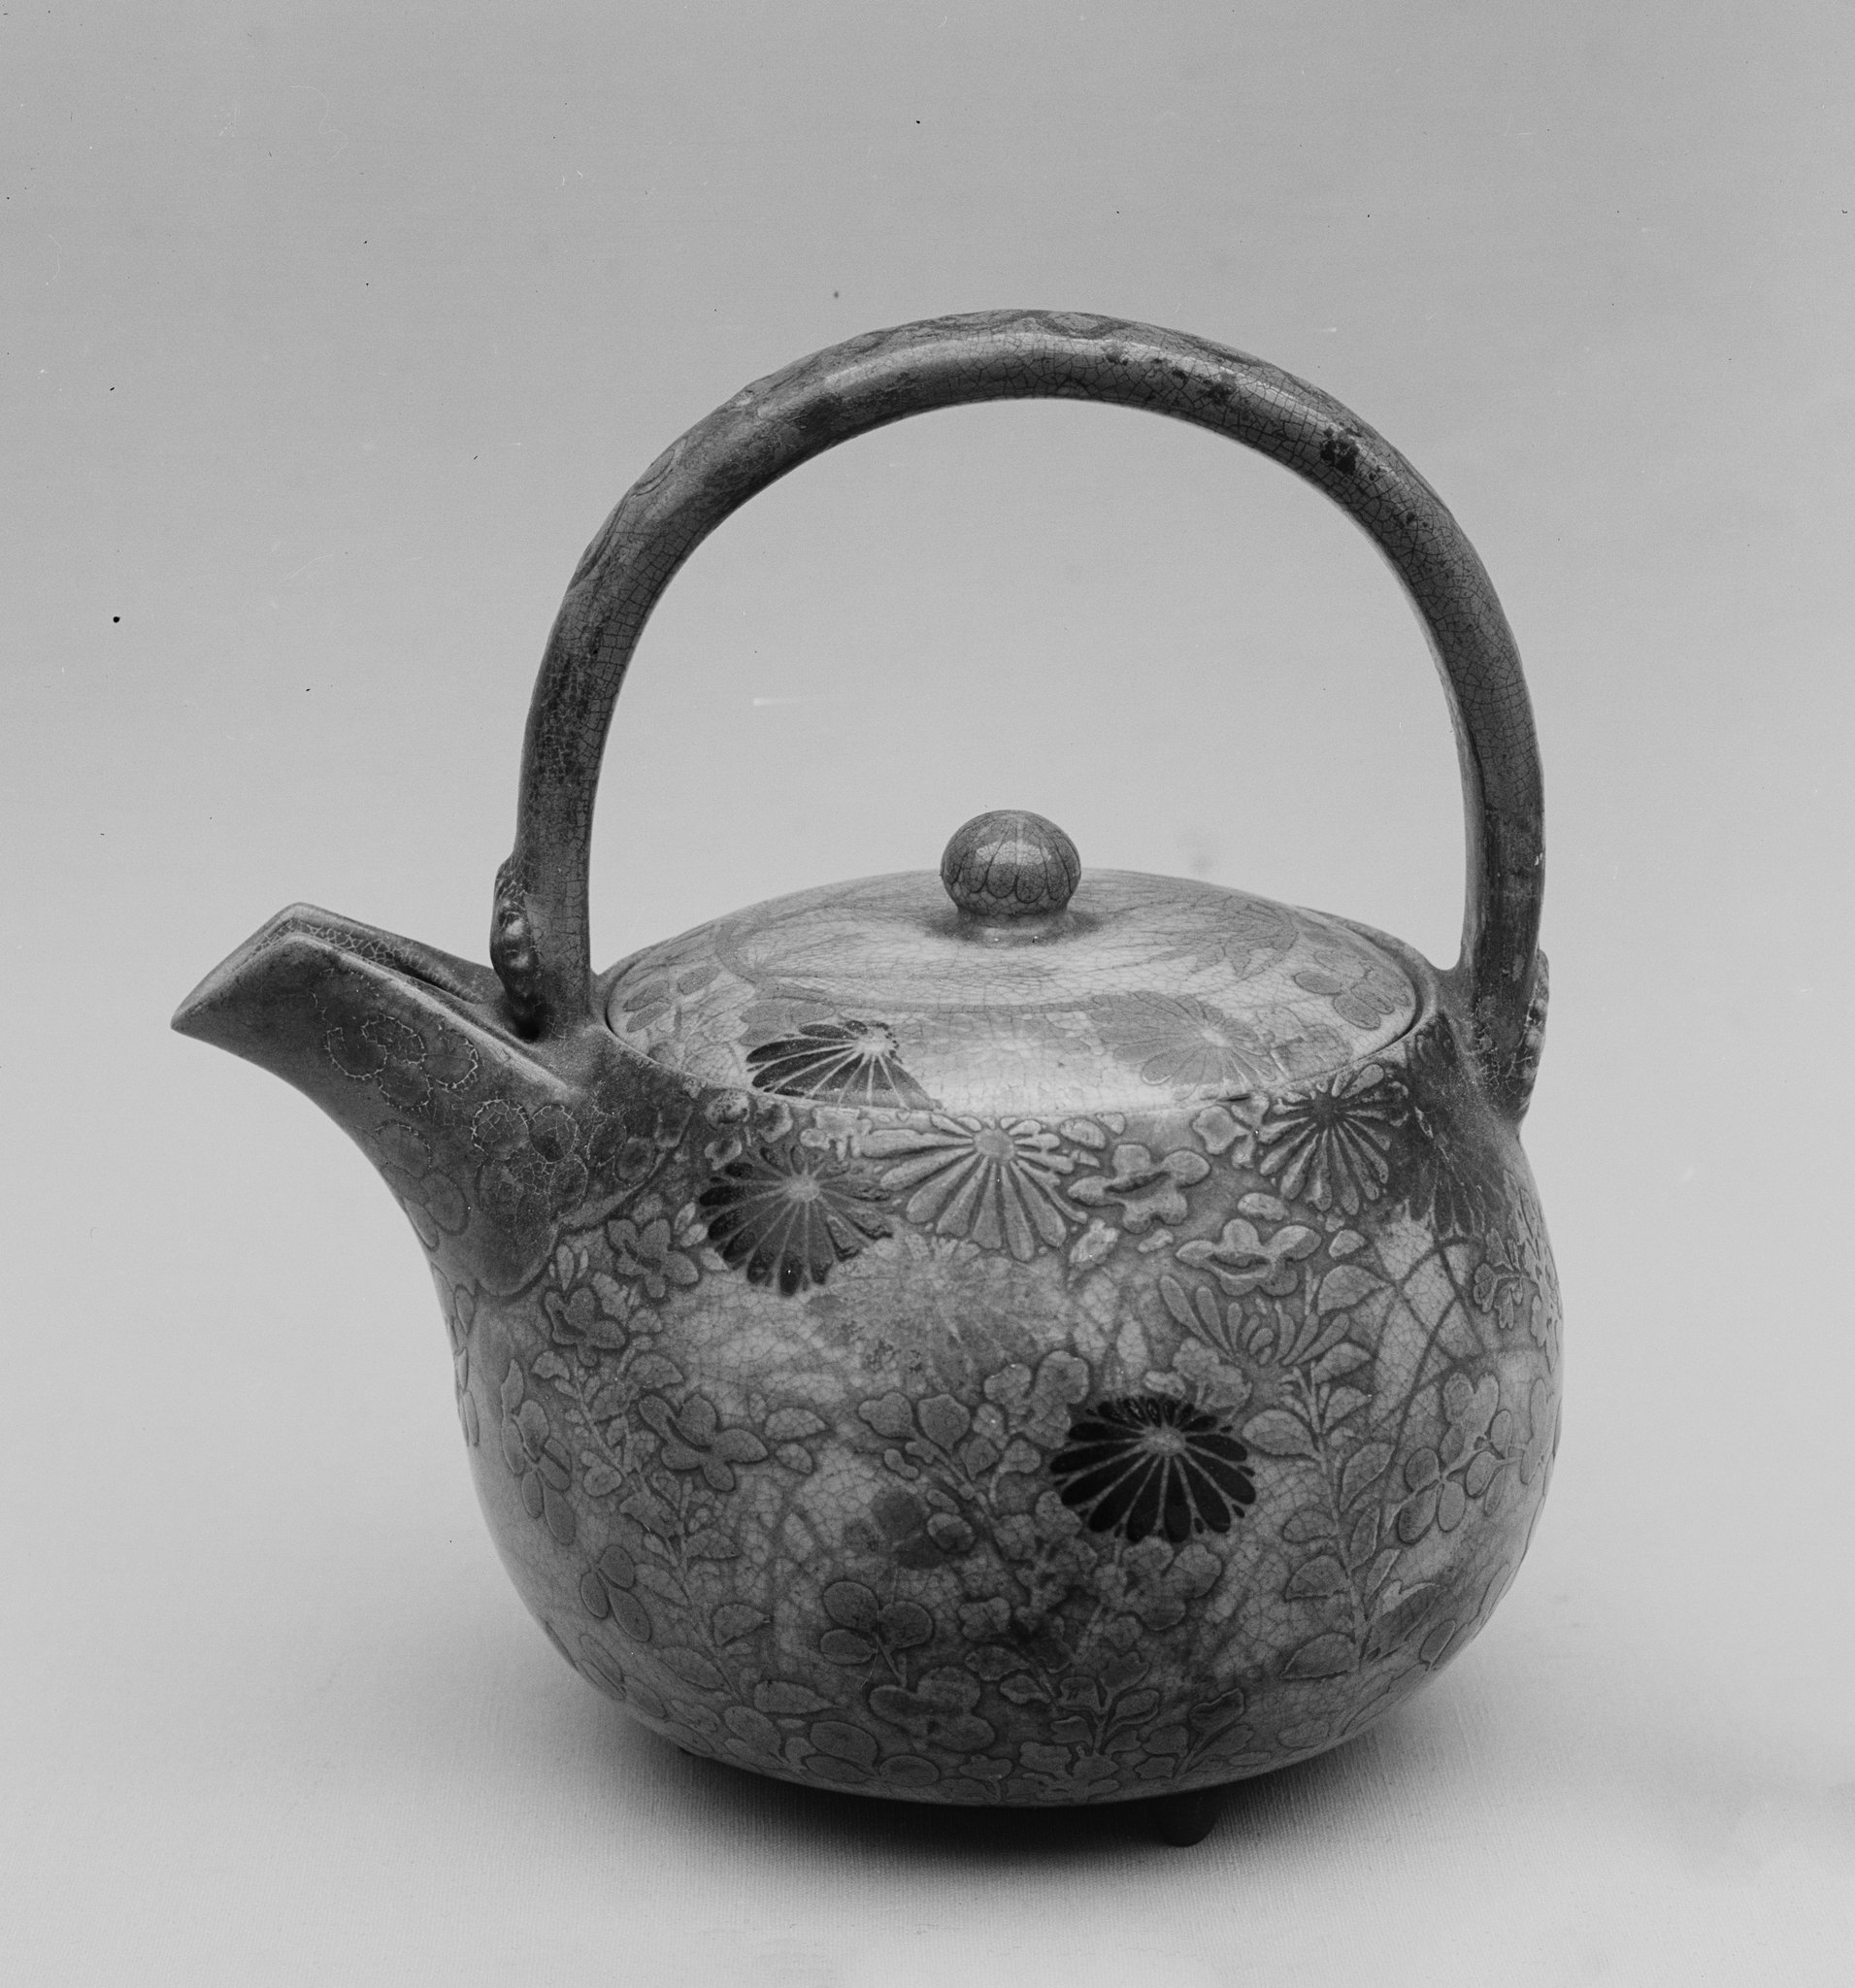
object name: wine kettle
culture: japanese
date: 1780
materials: clay, enamel, glaze, gold